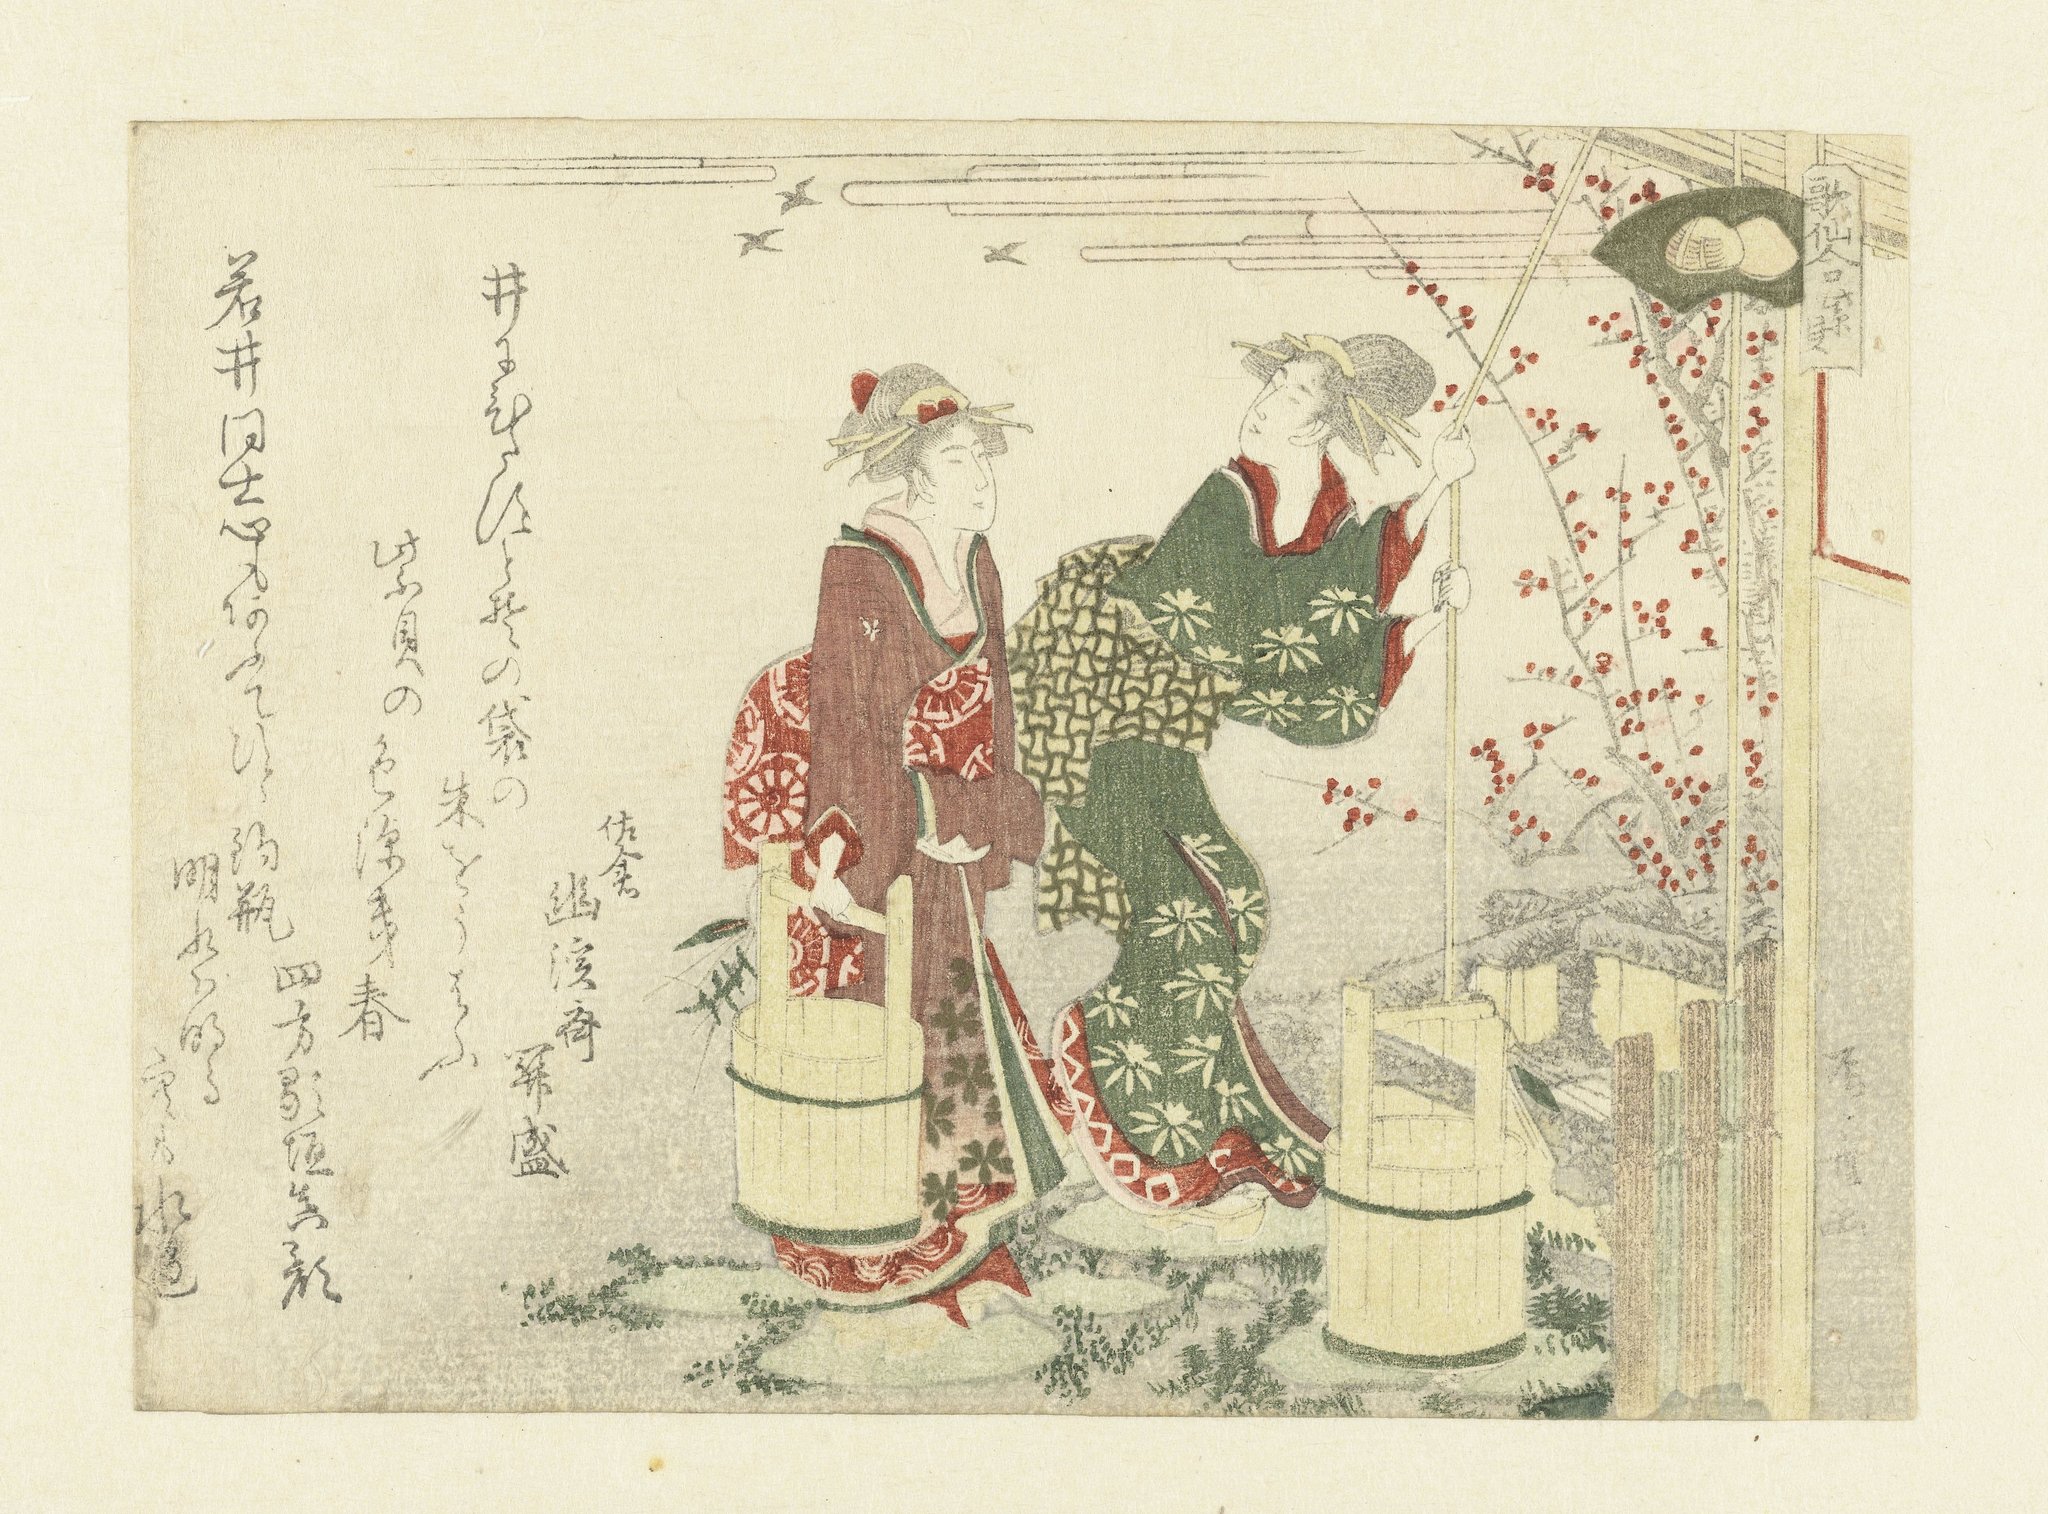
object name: print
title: Drawing Water from the Well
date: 1809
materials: paper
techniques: woodcut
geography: japan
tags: utilitarian, public pump or water fountain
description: Een surimono is een luxe uitgevoerde prent waarop beeld met één of meerdere gedichten gecombineerd is. Bij het drukken van een surimono werd vaak gebruik gemaakt van dikker papier, blinddruk en metaal pigmenten, zoals koper- en zilverpoeder. De prenten werden vaak in opdracht van dichters gemaakt en als exclusief geschenk aan vrienden en relaties gegeven.